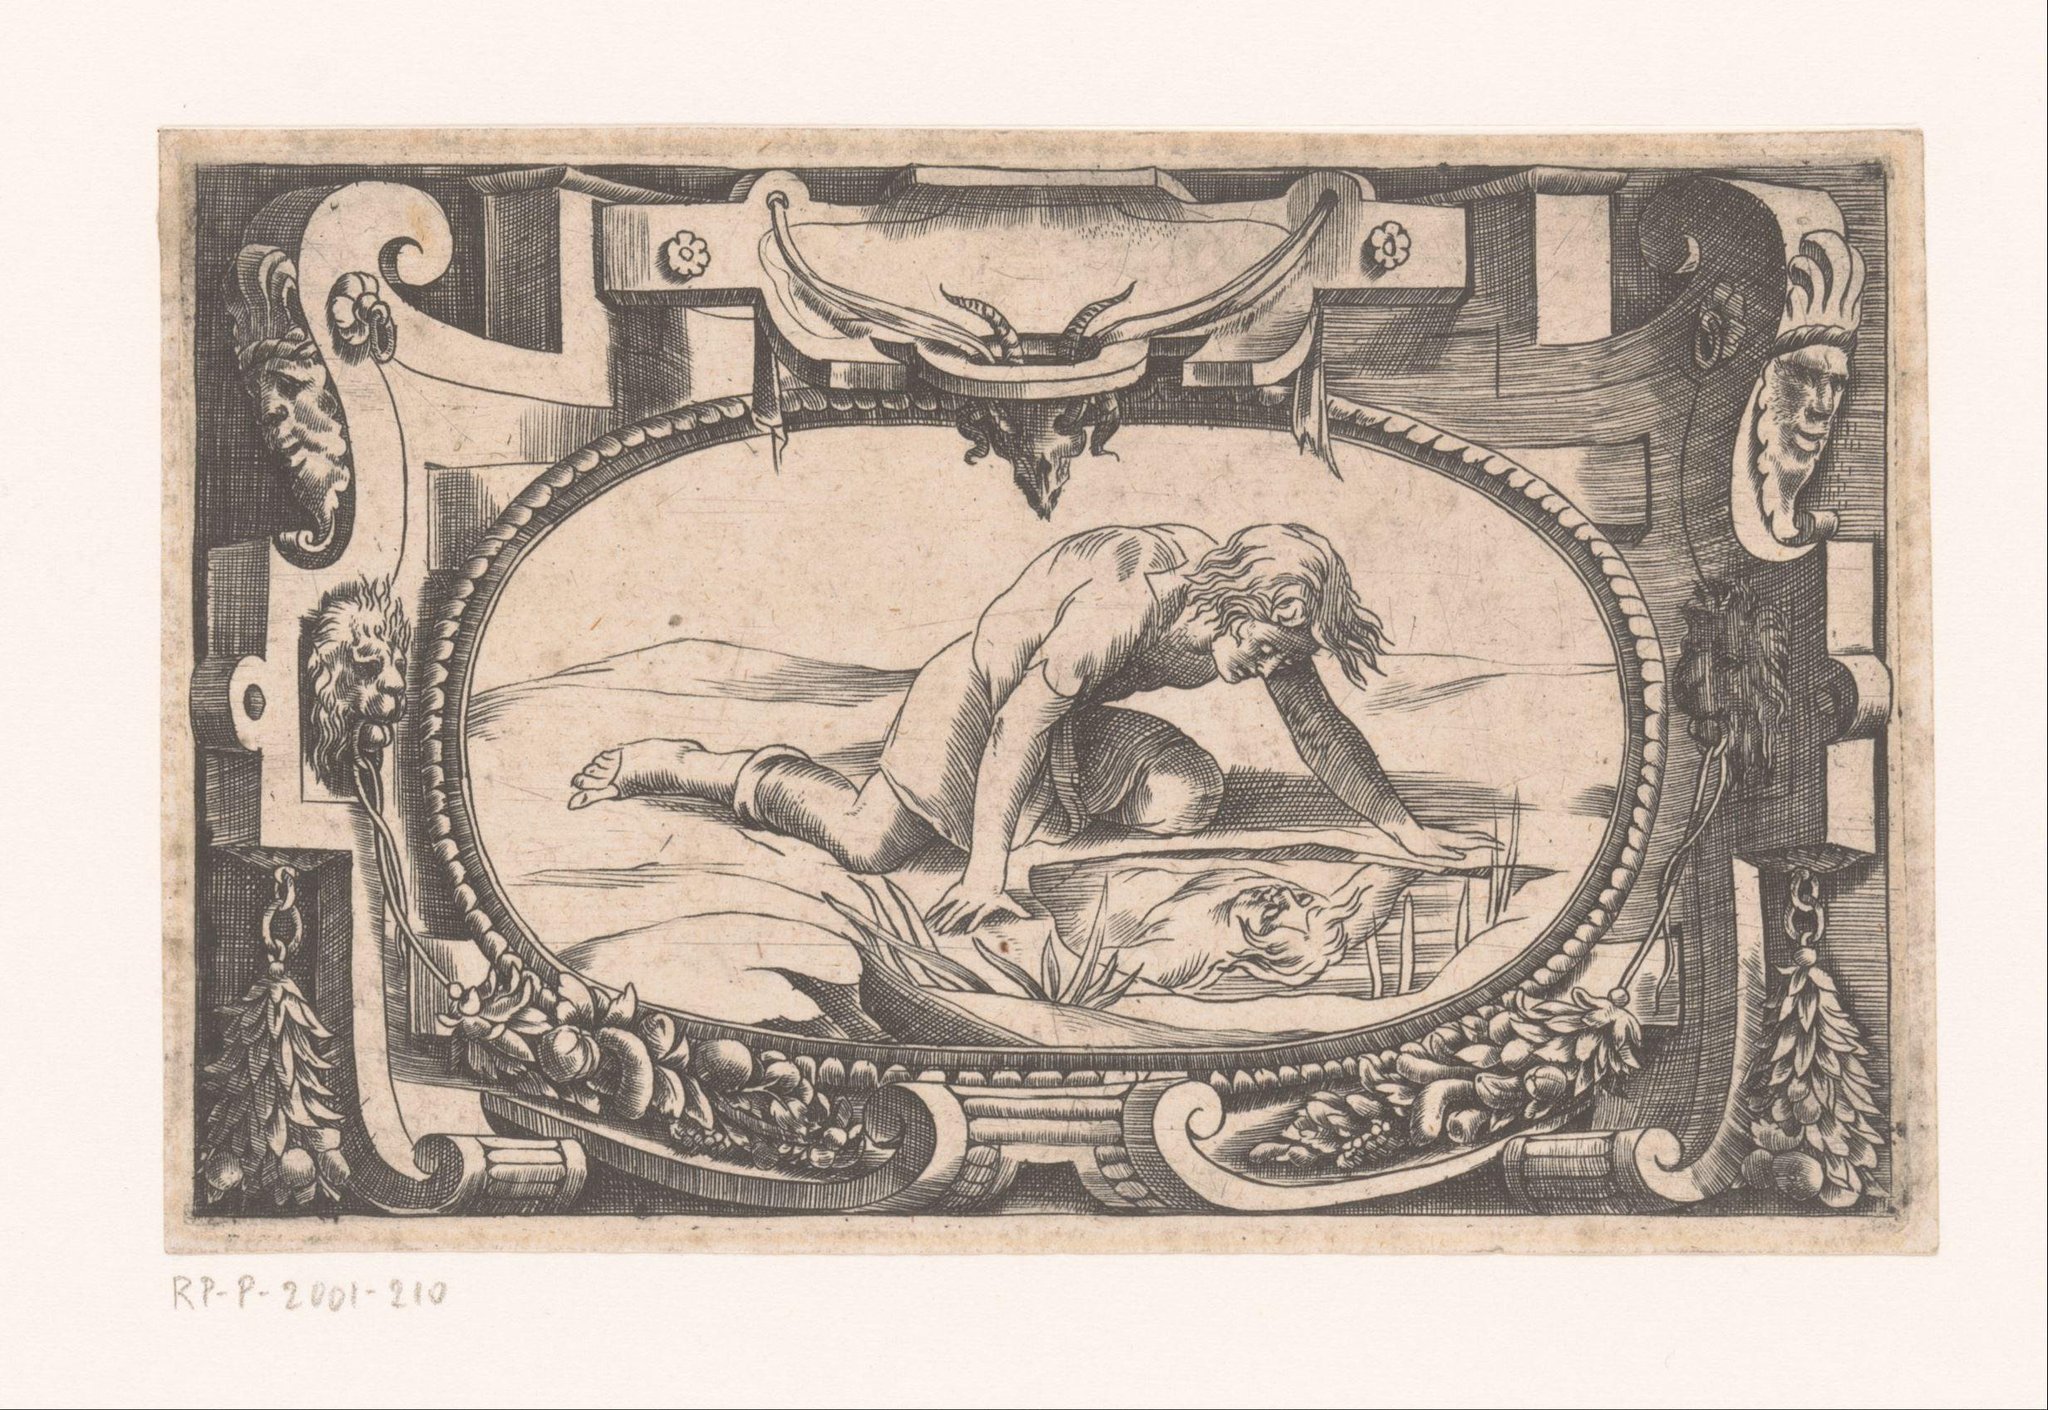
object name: print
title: Cartouches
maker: georges reverdy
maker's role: print maker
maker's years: 1450-1565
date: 1536-1569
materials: paper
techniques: engraving, etching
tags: narcissus, gazing in a fountain, falls in love with his own reflection; possibly the nymph echo peeps at the scene, ornament ~ cartouche, narcissus changed into a narcissus: when narcissus is pining away for the love of his image reflected from the water, he is changed into a narcissus (ovid, metamorphoses iii 510)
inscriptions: collector's mark: Lugt 2228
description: Prent maakt deel uit van een ongenummerde serie van drie prenten.